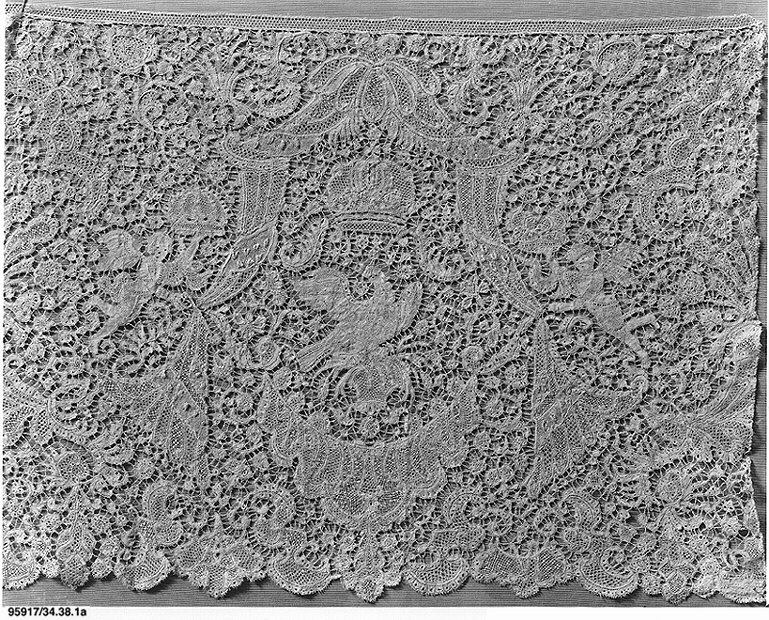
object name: flounce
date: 1724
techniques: lace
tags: eagles,angels